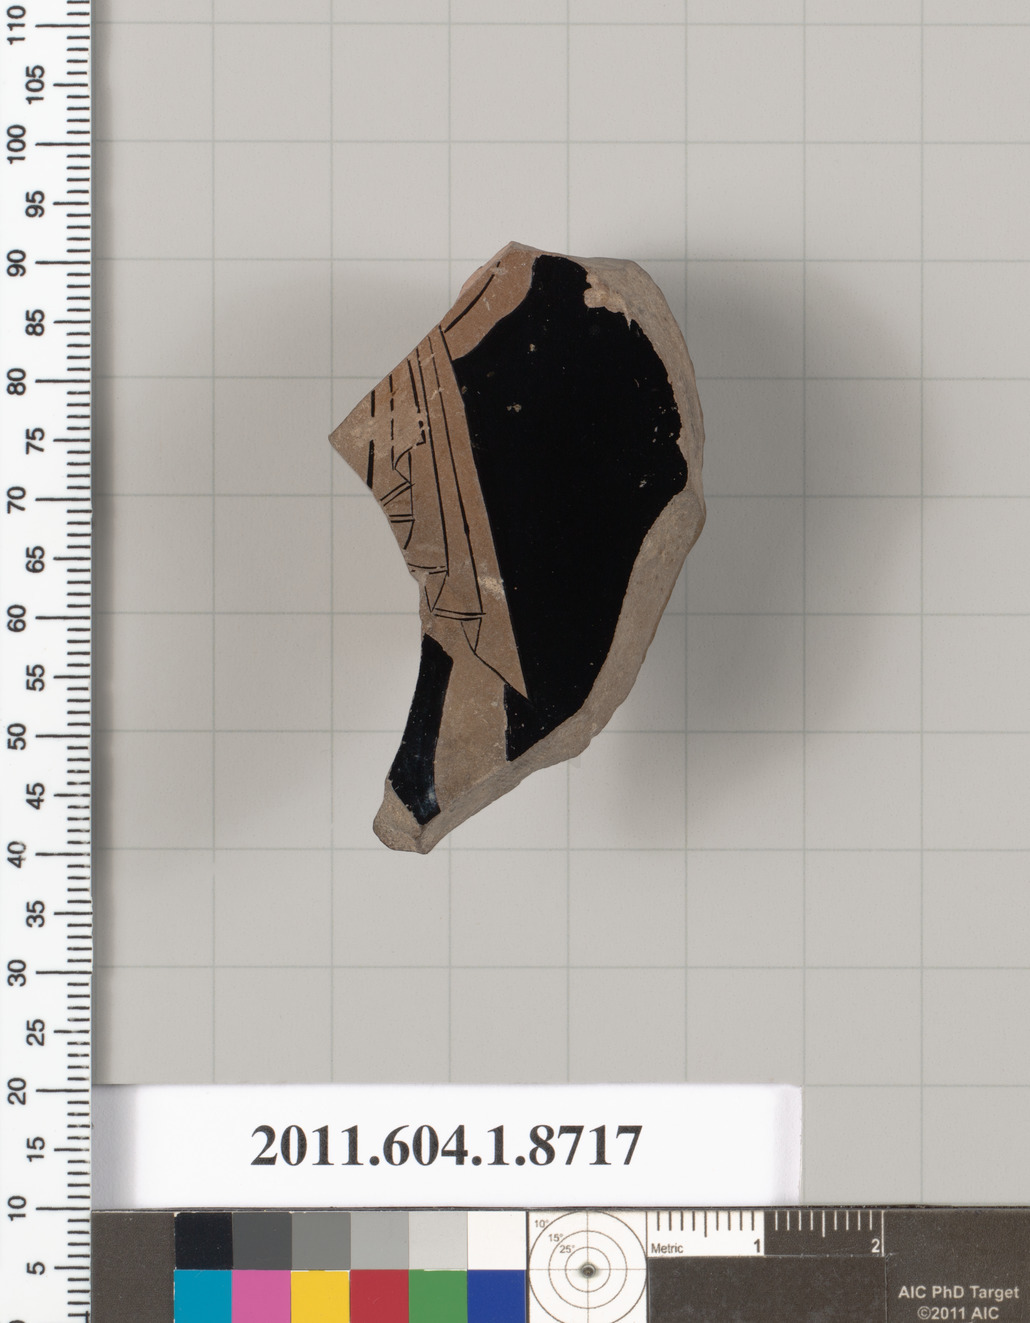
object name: kylix fragment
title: Terracotta fragment of a kylix (drinking cup)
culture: greek, attic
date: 490-480 BCE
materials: terracotta